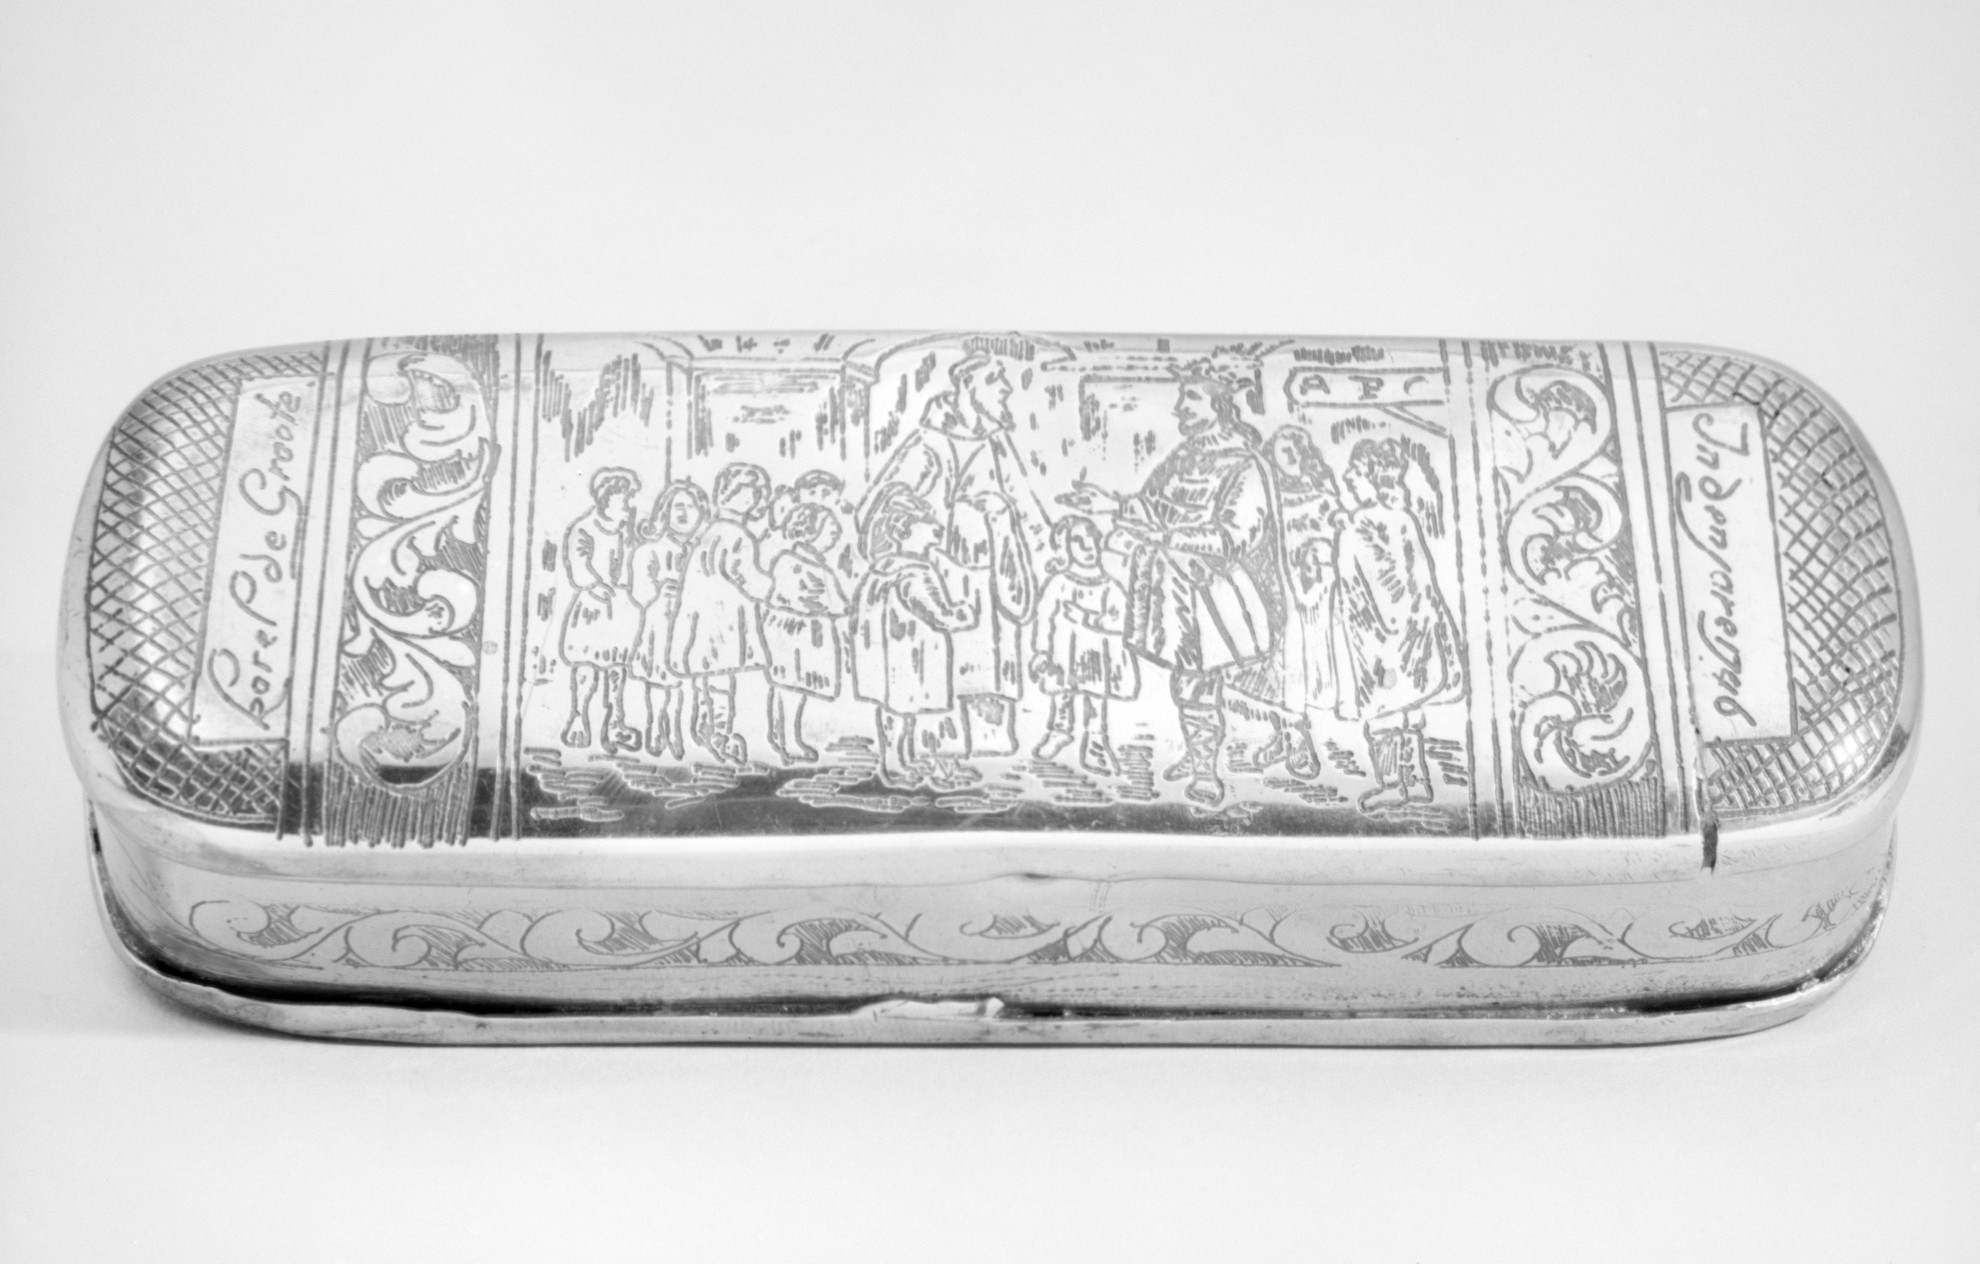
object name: tobacco box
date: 1746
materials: brass, copper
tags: men